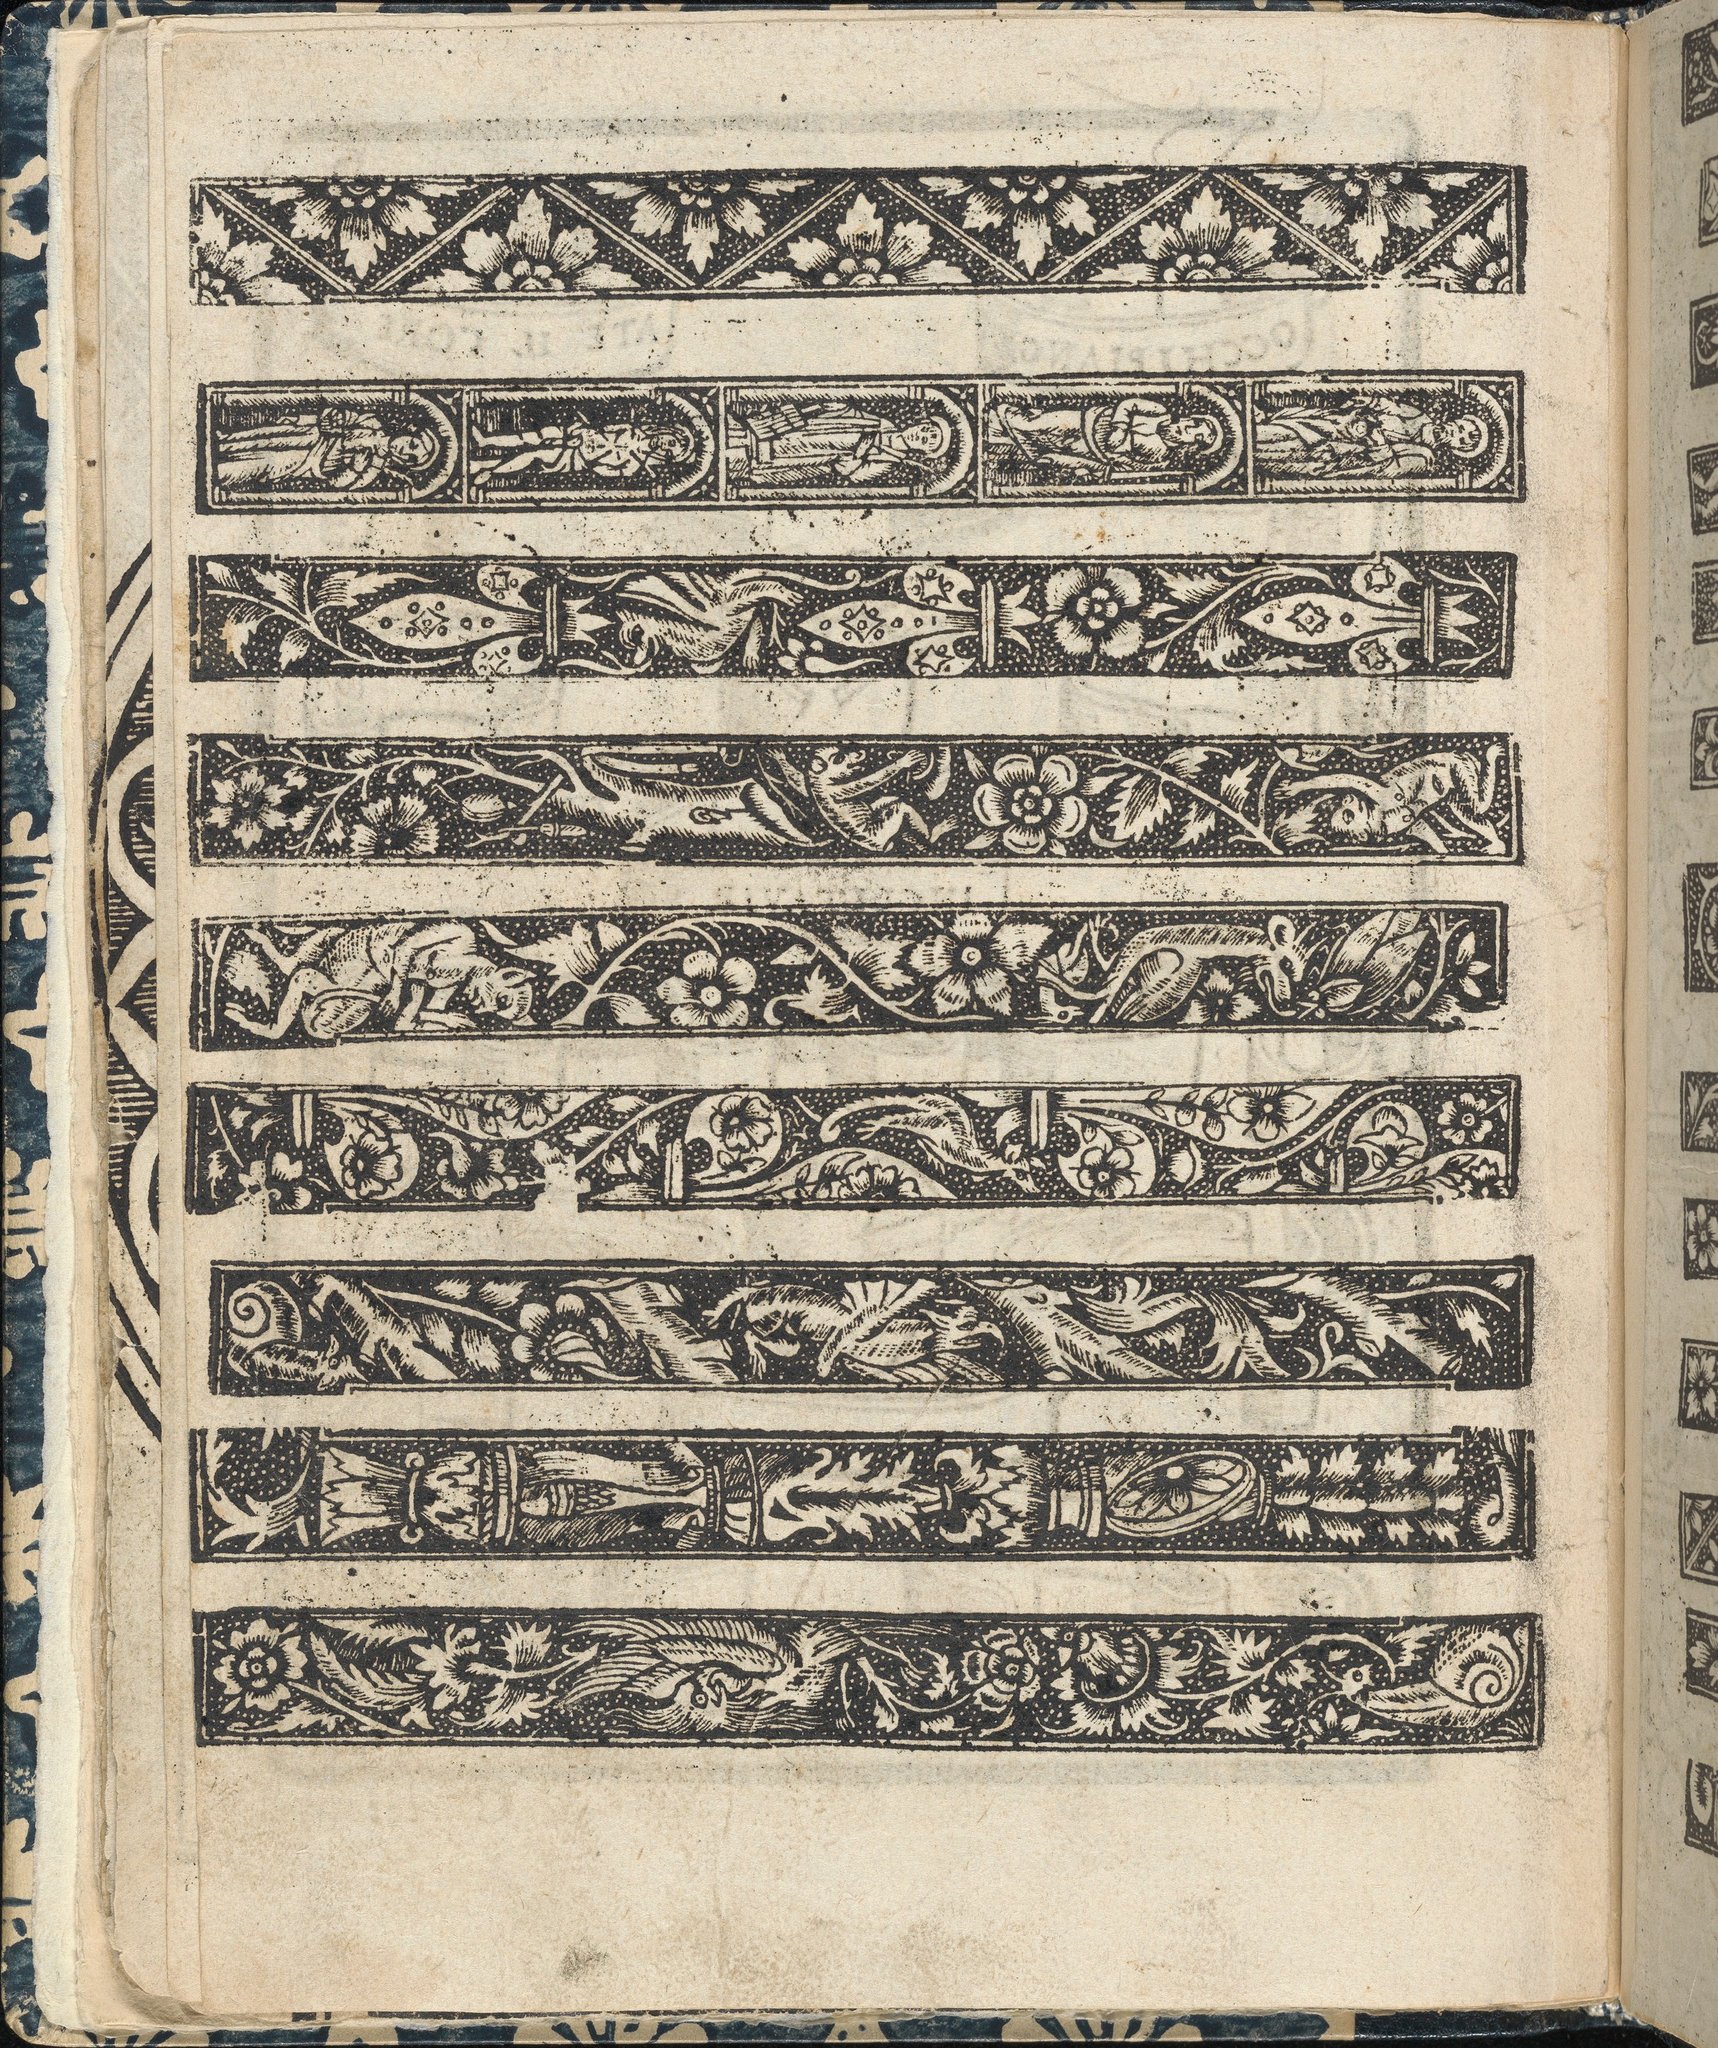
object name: book print ornament architecture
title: Essempio di recammi, page 19 (verso)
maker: giovanni antonio tagliente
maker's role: author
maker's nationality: italian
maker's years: 1465-1528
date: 1530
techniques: woodcut